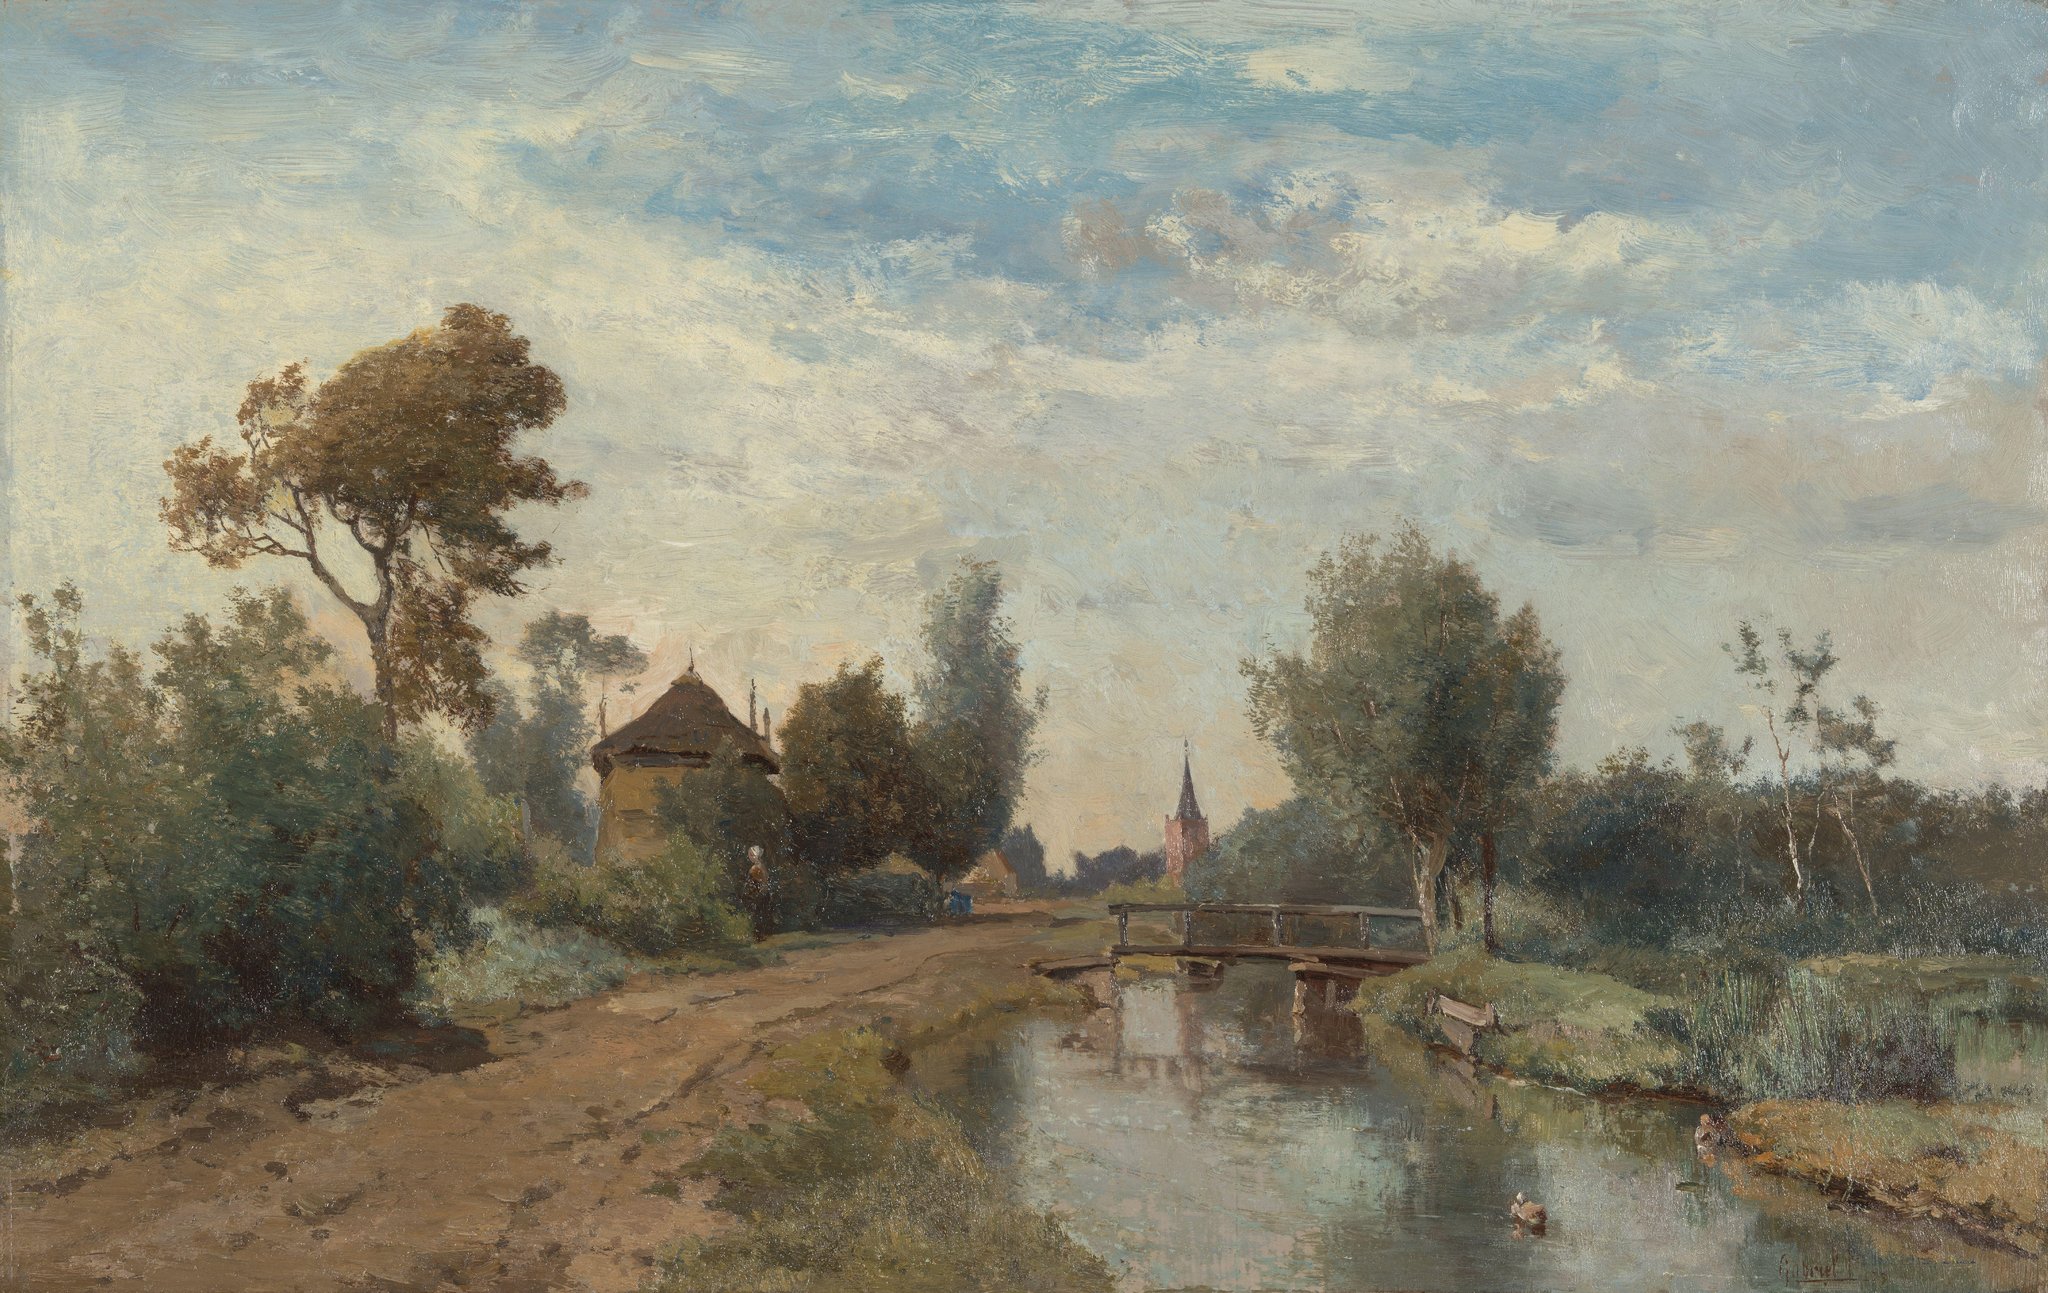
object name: painting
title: Landscape near Kortenhoef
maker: paul joseph constantin gabriël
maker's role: draughtsman, print maker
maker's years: 1828-1903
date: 1877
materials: oil, panel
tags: water course (+ landscape with figures, staffage)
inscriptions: signature and date: ‘Gabriel f 77.’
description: Cities expanded rapidly in the late 19th century. Within 50 years, Amsterdam’s population doubled. Many artists wanted to escape the modern cities and move to the country in search of peaceful nature. However, in the Netherlands, even the countryside had been intensively transformed by man. For centuries, vast strips of sea have been dried up to increase the land surface.